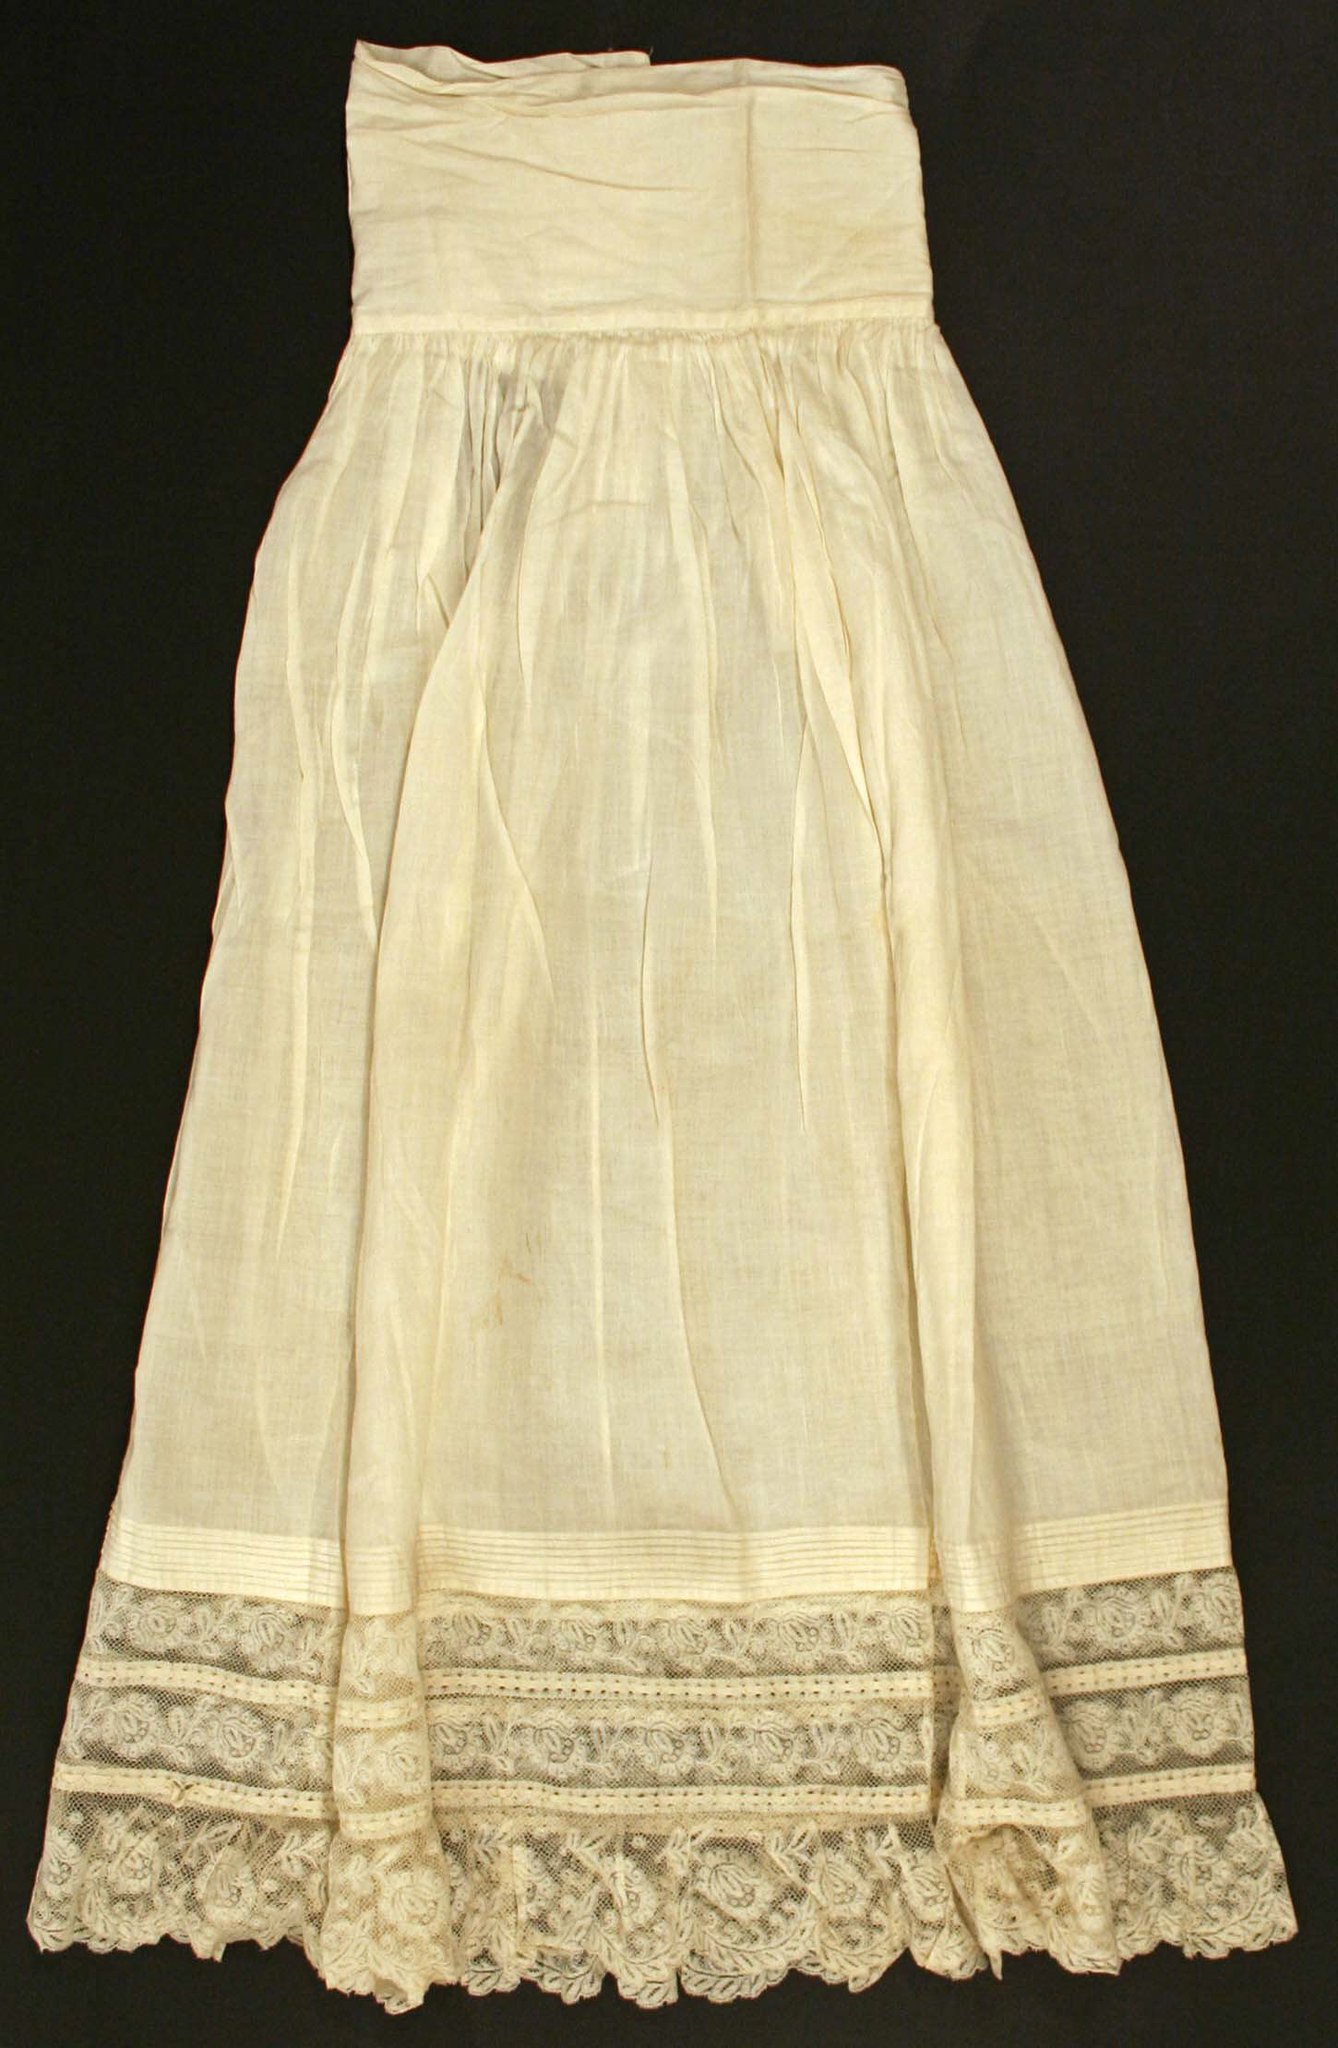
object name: petticoat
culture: american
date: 1867-1900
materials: cotton